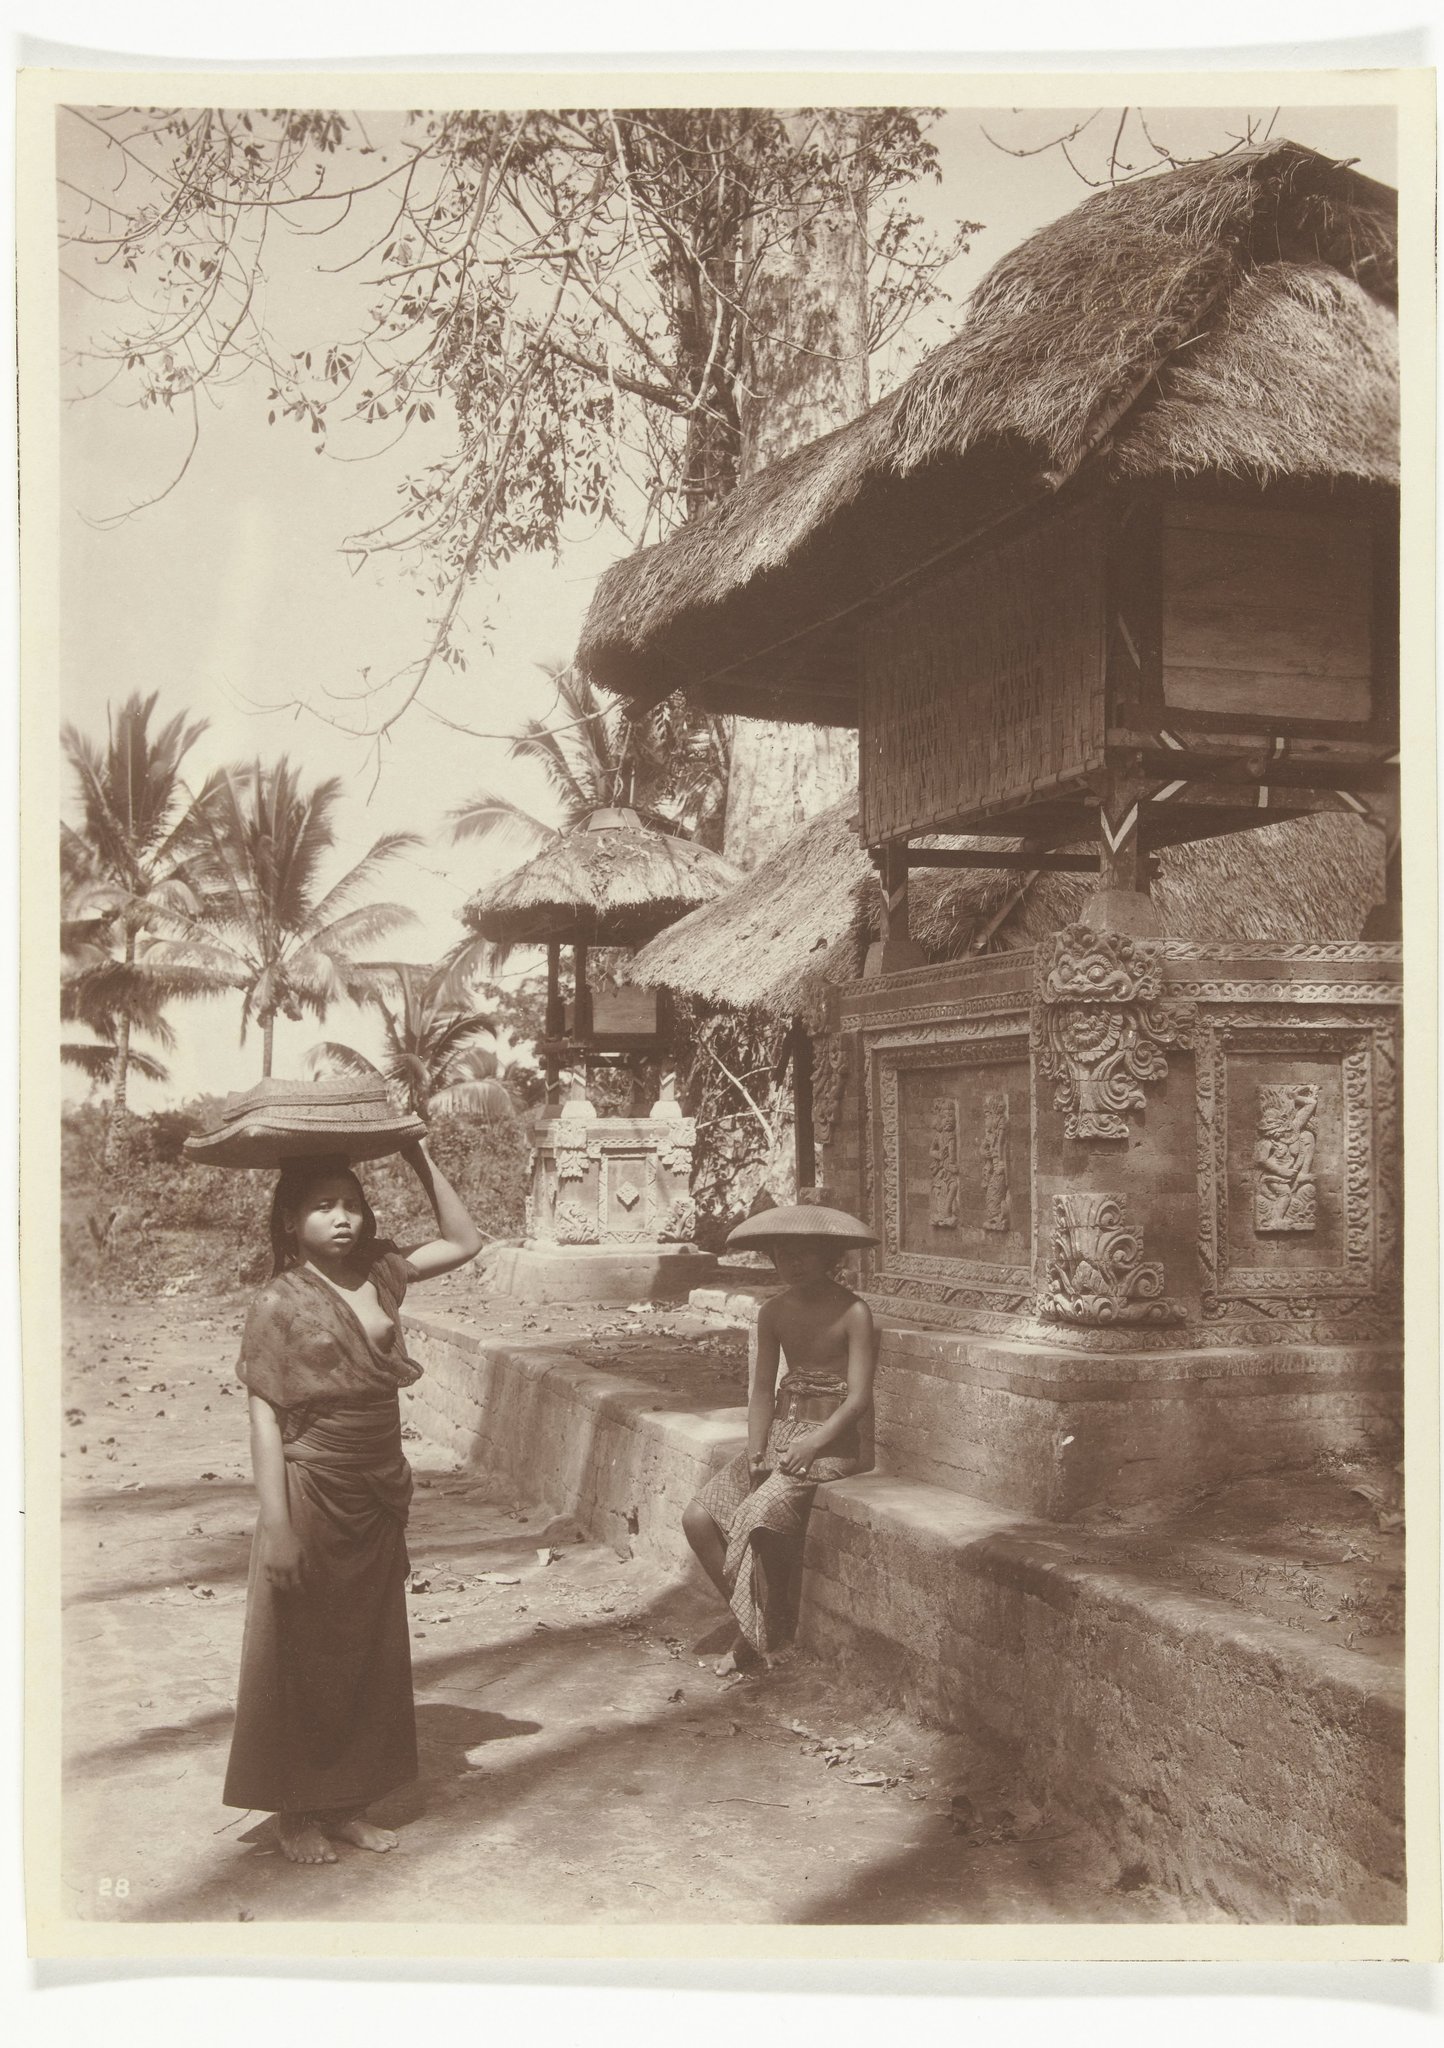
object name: photograph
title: Offerplaats op Bali, voormalig Nederlands-Indië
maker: onnes kurkdjian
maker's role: fotograaf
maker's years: 1851-1903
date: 1890-1910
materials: paper, photographic support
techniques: gelatin silver print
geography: dutch east indies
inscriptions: stamp: ‘Foto Kurkdjian, Soerabaia (...)’, check stamp: ‘Kurkdjian / Sourabaia Java’, number: ‘28’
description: Een jongevrouw en een jongeman bij een offerplaats op Bali, voormalig Nederlands-Indië.